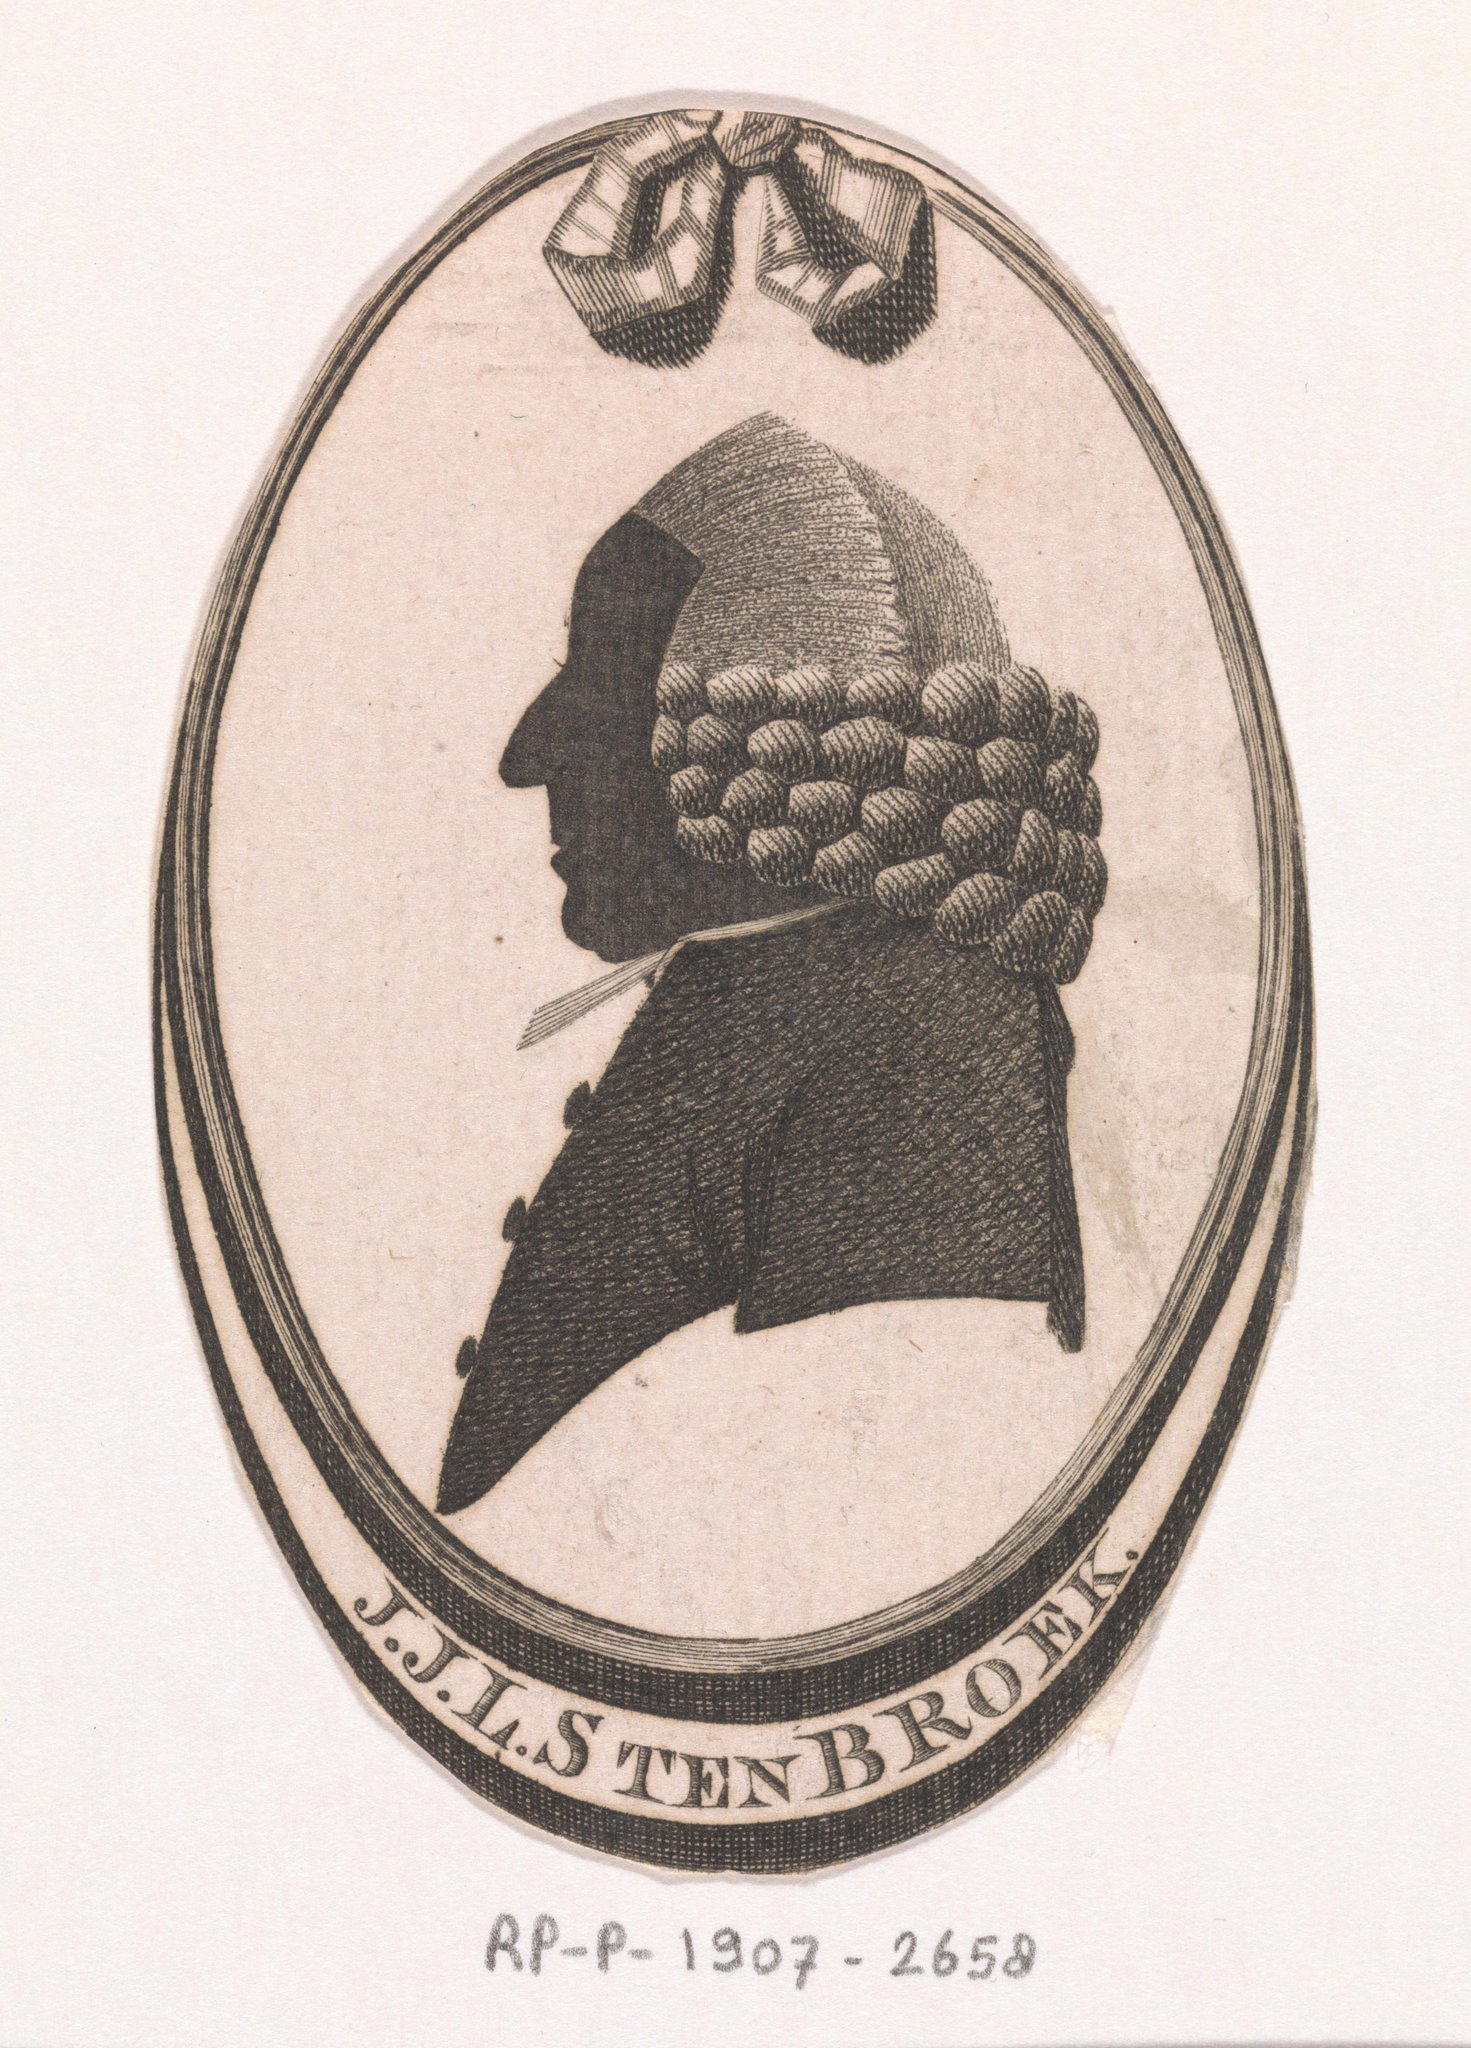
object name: print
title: Silhouetportret van Johan Jacob le Sage ten Broek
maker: govert kitsen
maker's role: print maker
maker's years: 1766-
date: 1776-1810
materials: paper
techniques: engraving, etching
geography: rotterdam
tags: wig (+ sideview, profile)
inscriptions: collector's mark: Lugt 2228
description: Portret van de predikant Johan Jacob le Sage ten Broek. Hij draagt een batterijpruik en bef. Buste in profiel in ovale lijst met strik bovenaan.